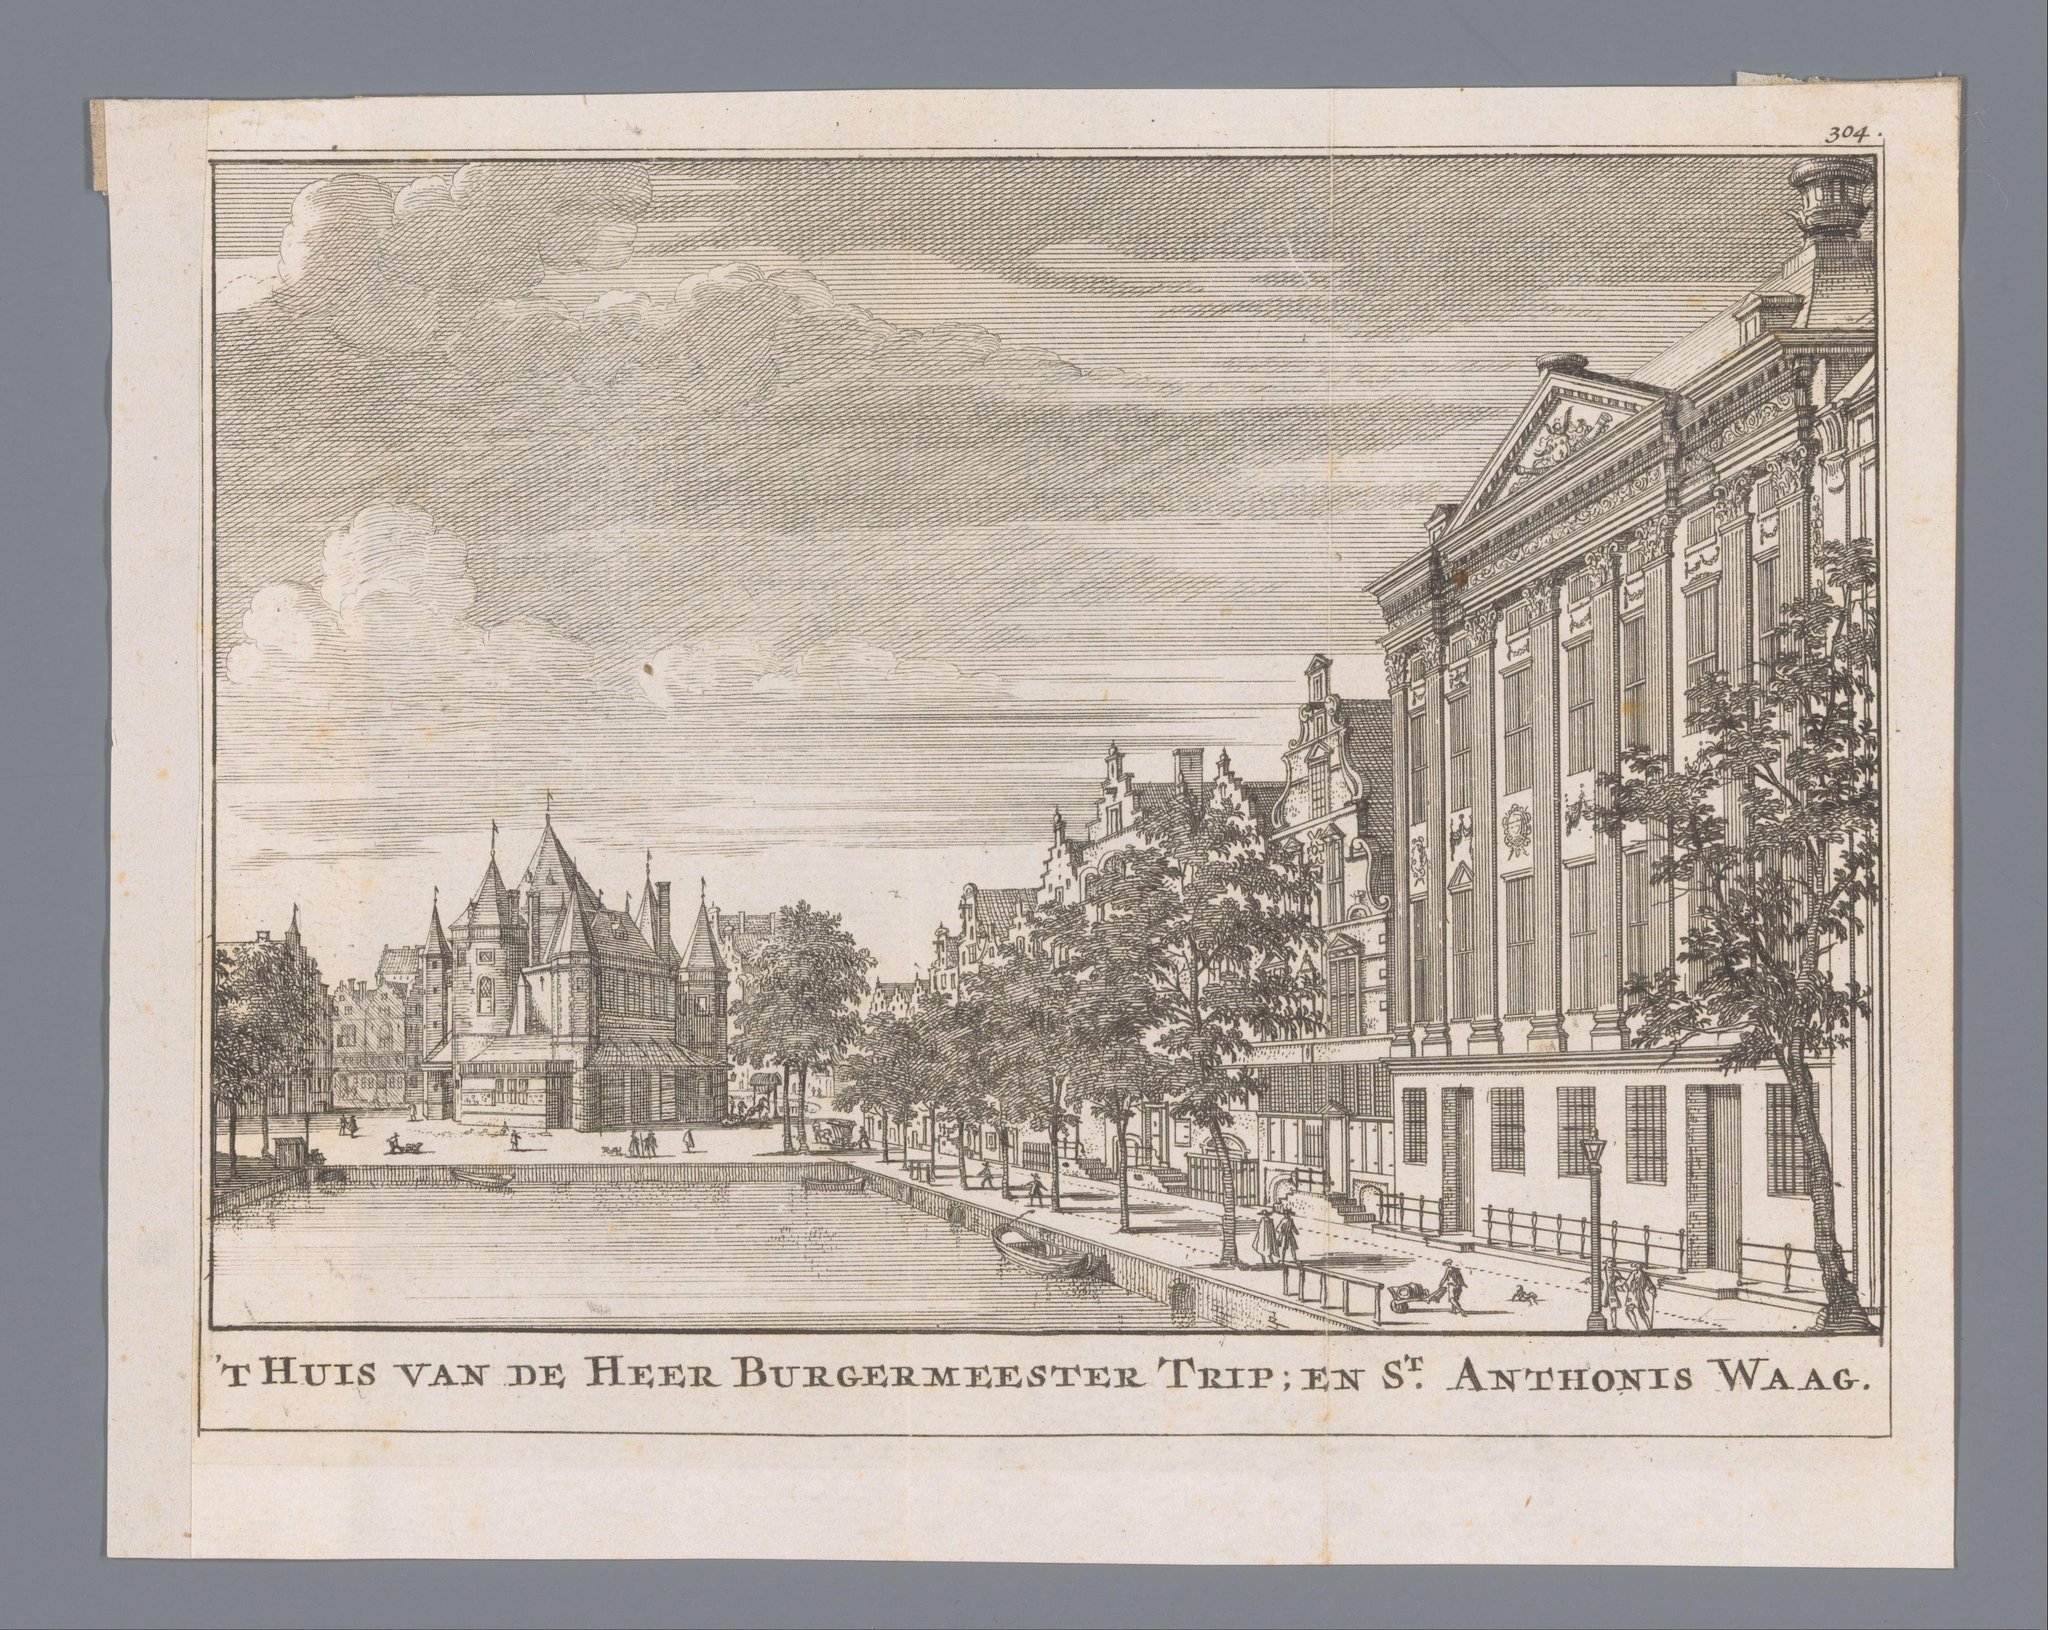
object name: book illustration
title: 't Huis van de heer burgemeester Trip; en St. Anthonis Waag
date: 1726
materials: paper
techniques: engraving, etching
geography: amsterdam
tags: urban housing, canals, waters (in city), weigh-house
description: Prent gebruikt in: Hoorn, Nicolaas ten. Wegwyzer door Amsterdam, Zynde eene beknopte verhandeling van desselfs eerste opkomst, vergrootingen, en teegenwoordigen staat (…). Tweede druk. Amsterdam: Nicolaas ten Hoorn, 1726, p. 304. En in de latere edities (Amsterdam: erven J. Ratelband & Co, 1737, en Amsterdam: Pieter Meyer, 1751). In de eerste editie heeft deze prent een andere plek in het boek, en een ander nummer (285).